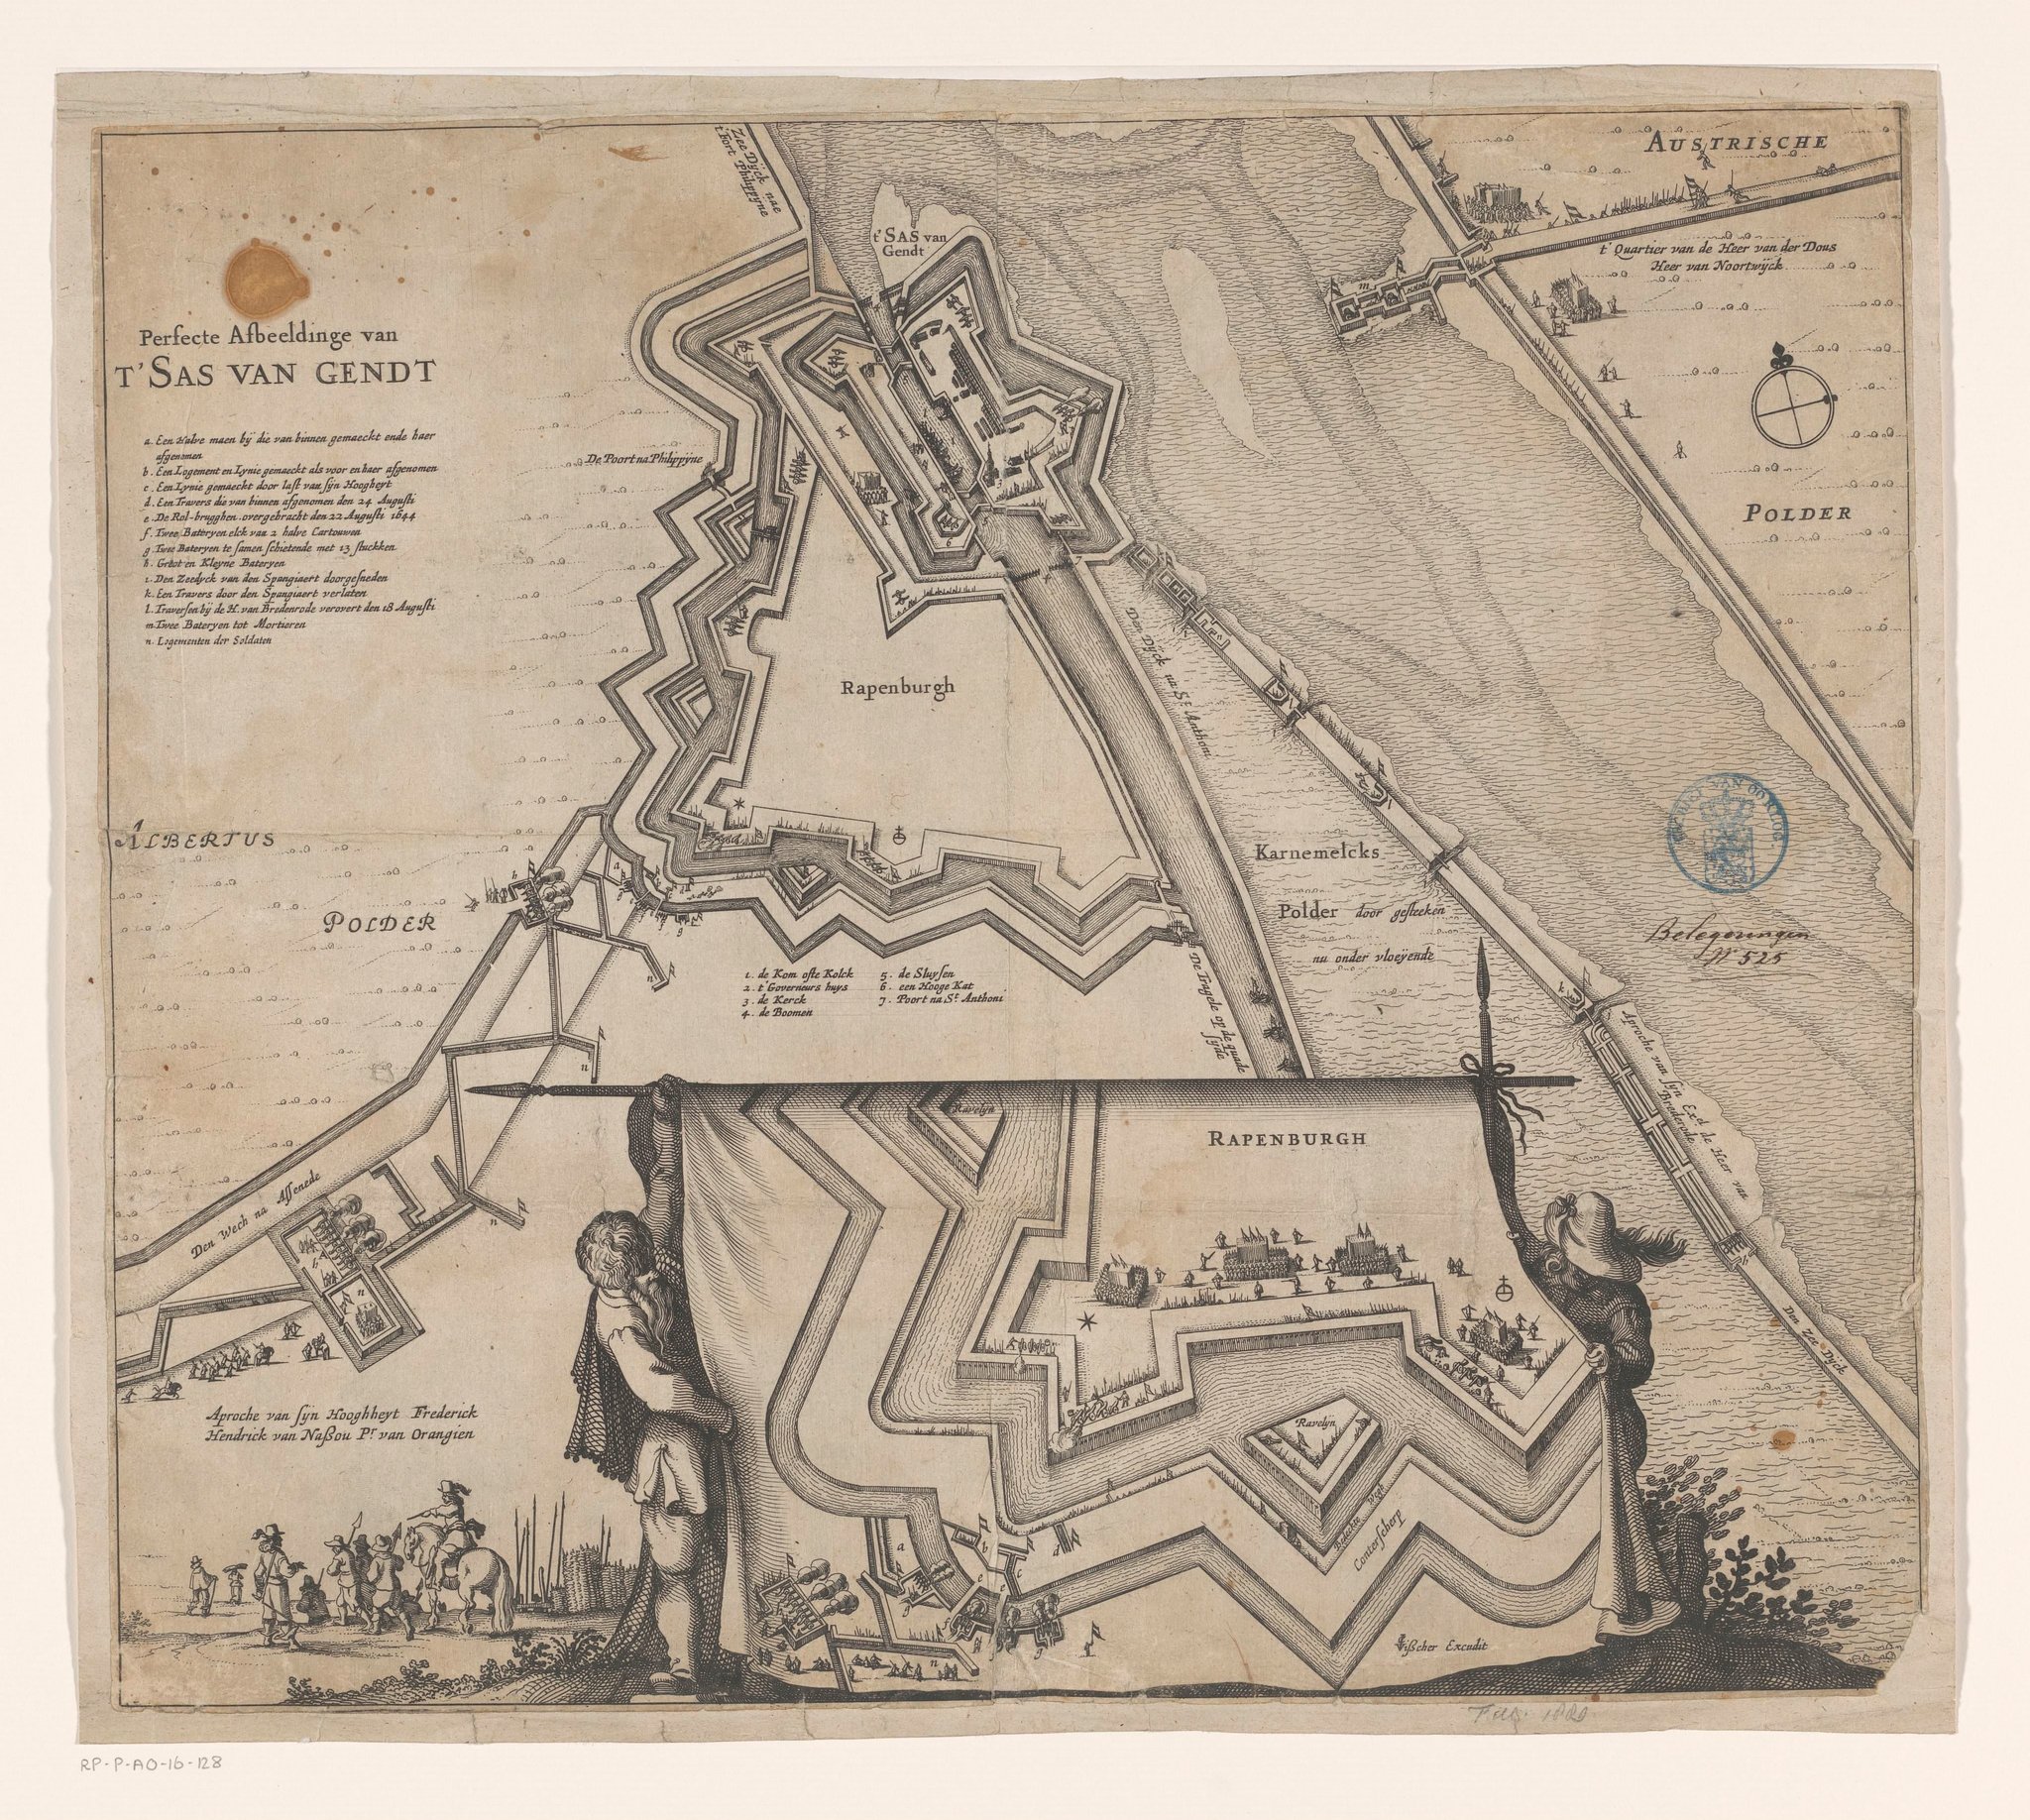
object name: print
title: Perfecte afbeeldinge van t' Sas van Gendt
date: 1644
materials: paper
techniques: engraving, etching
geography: amsterdam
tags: delft, the hague, frederick henry (prince of orange), fortress, siege, position war, maps of cities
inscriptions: collector's mark: Lugt 19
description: Plattegrond van Sas van Gent, belegerd door het Staatse leger onder Frederik Hendrik, begonnen 28 juli en ingenomen op 5 september 1644. Plattegrond van de versterkingen rond Sas-van-Gent, onderaan twee mannen met een doek waarop een uitvergroot detail van de beschietingen bij de ravelijnen bij het Rapenburg te zien is. Linksboven de titel en de legenda a-n.